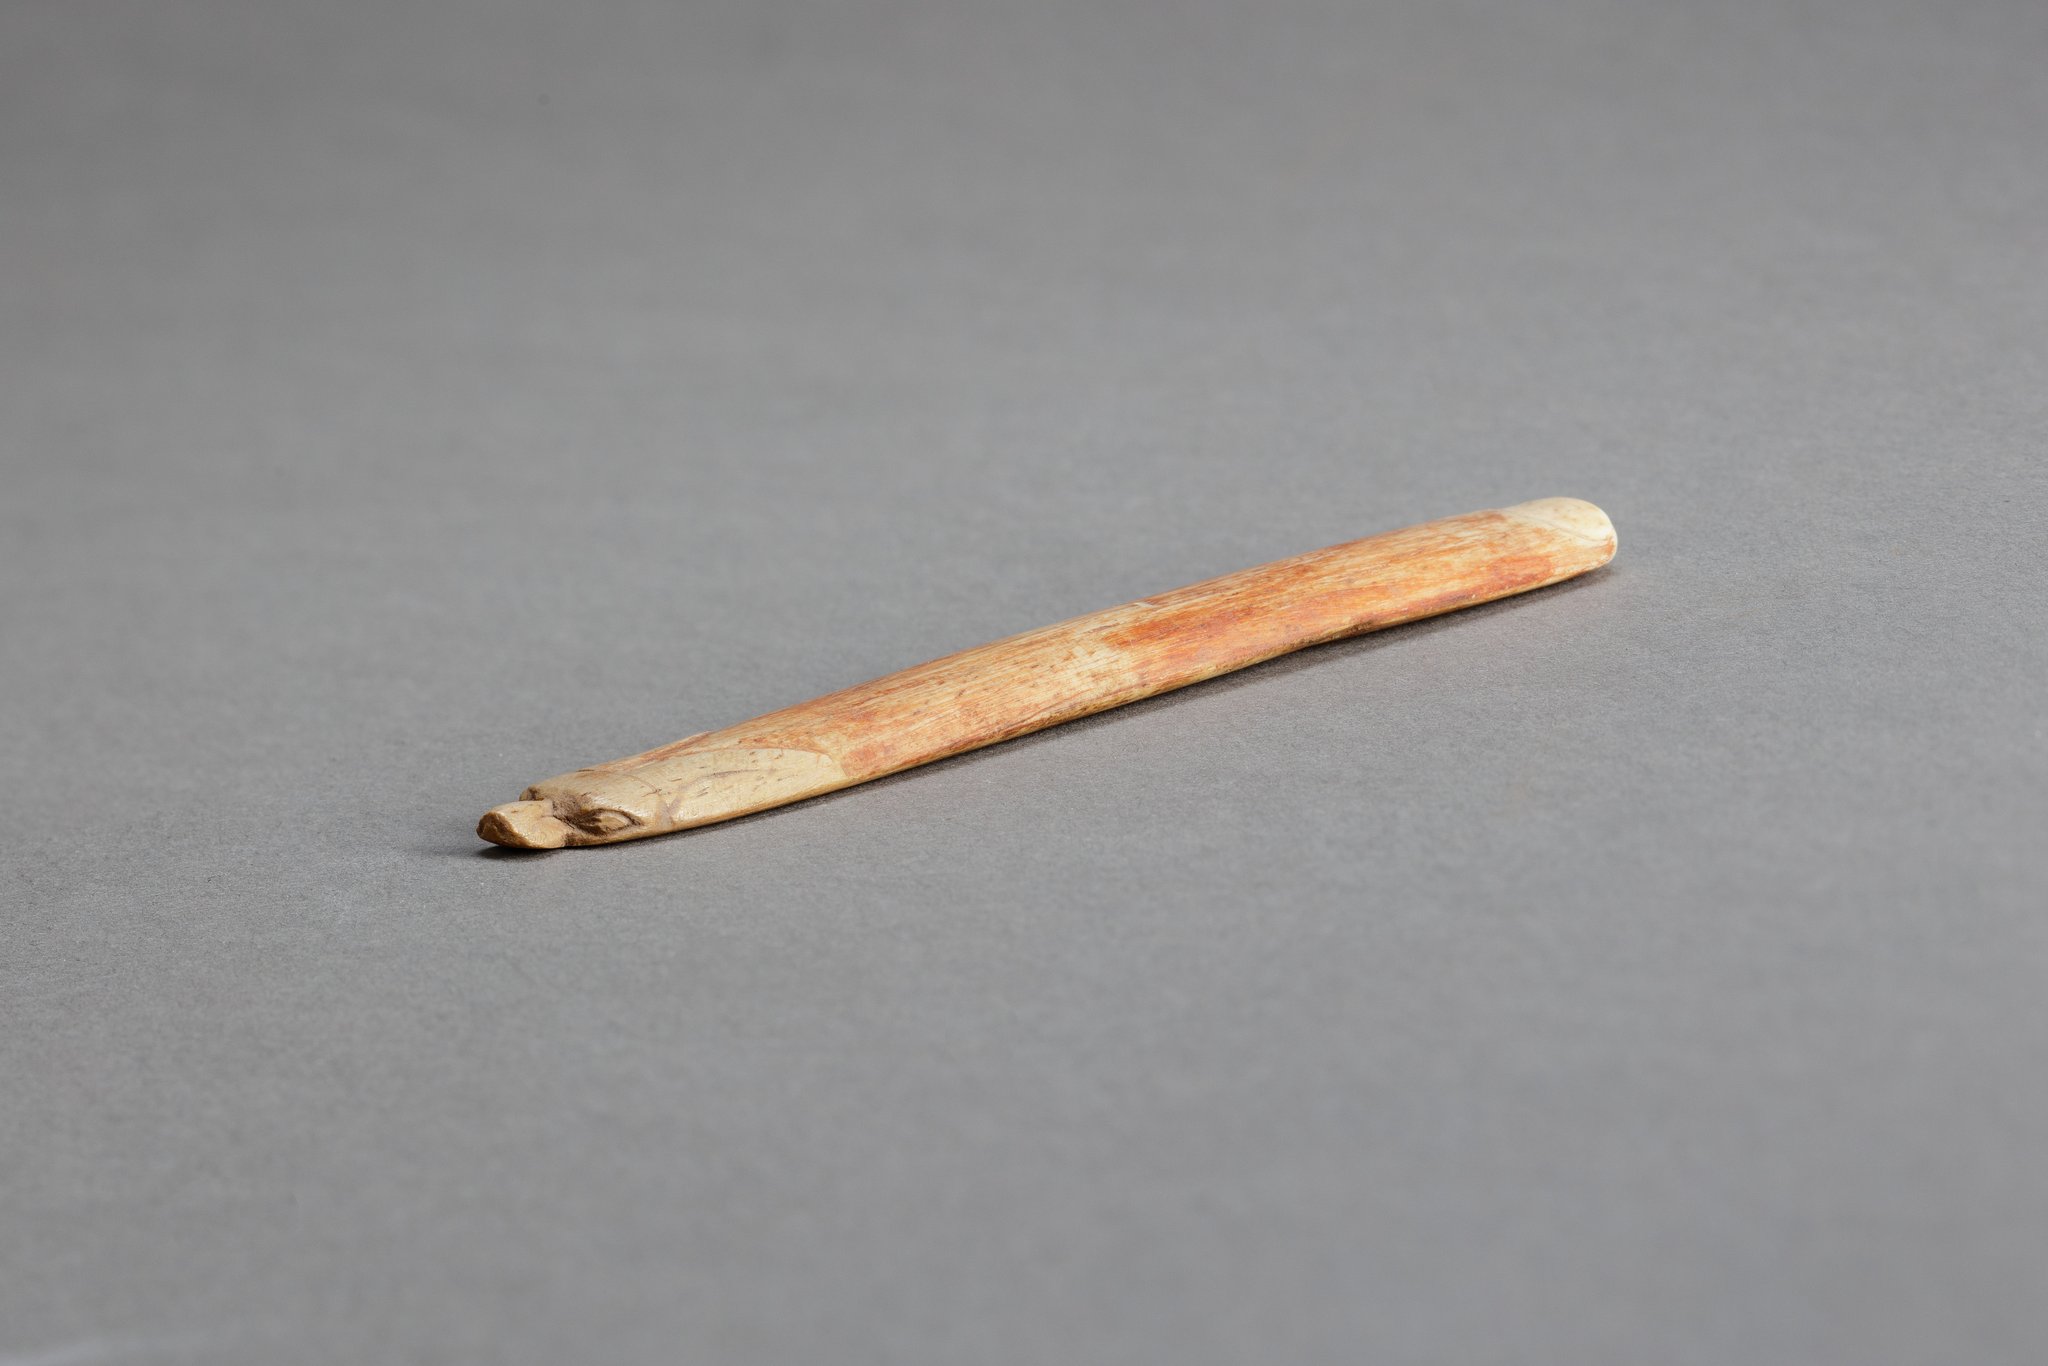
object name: game throw stick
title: Throw Stick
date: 1400-1295 BCE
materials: ivory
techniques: tinting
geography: upper egypt, thebes